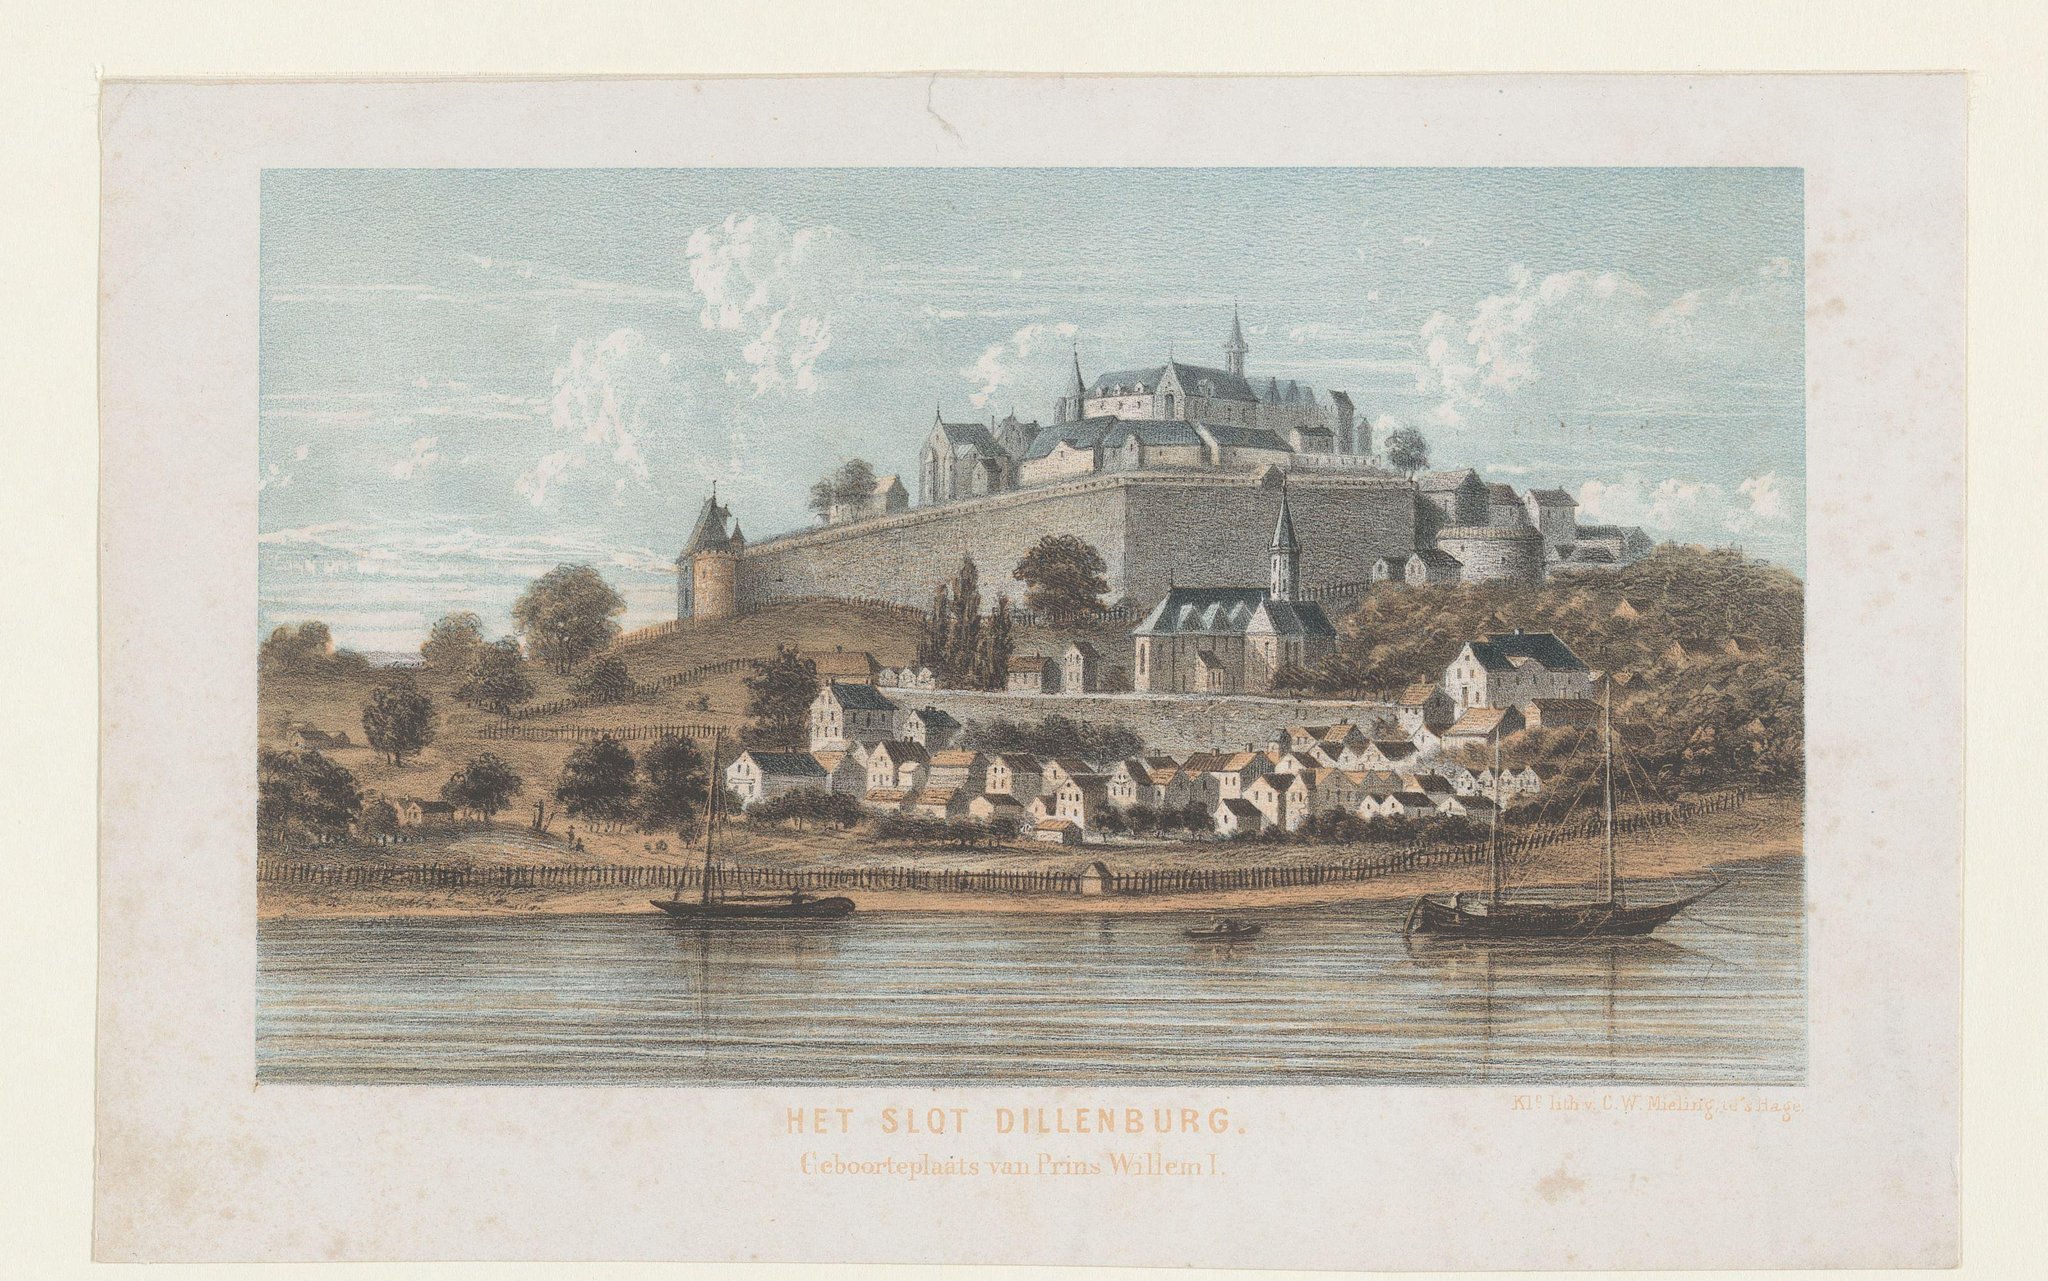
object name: print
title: Gezicht op Dillenburg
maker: carl wilhelm mieling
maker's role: print maker, printer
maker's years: 1815-1903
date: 1845-1863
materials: paper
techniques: lithograph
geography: the hague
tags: prospect of village, silhouette of village, castle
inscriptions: collector's mark: Lugt 2228